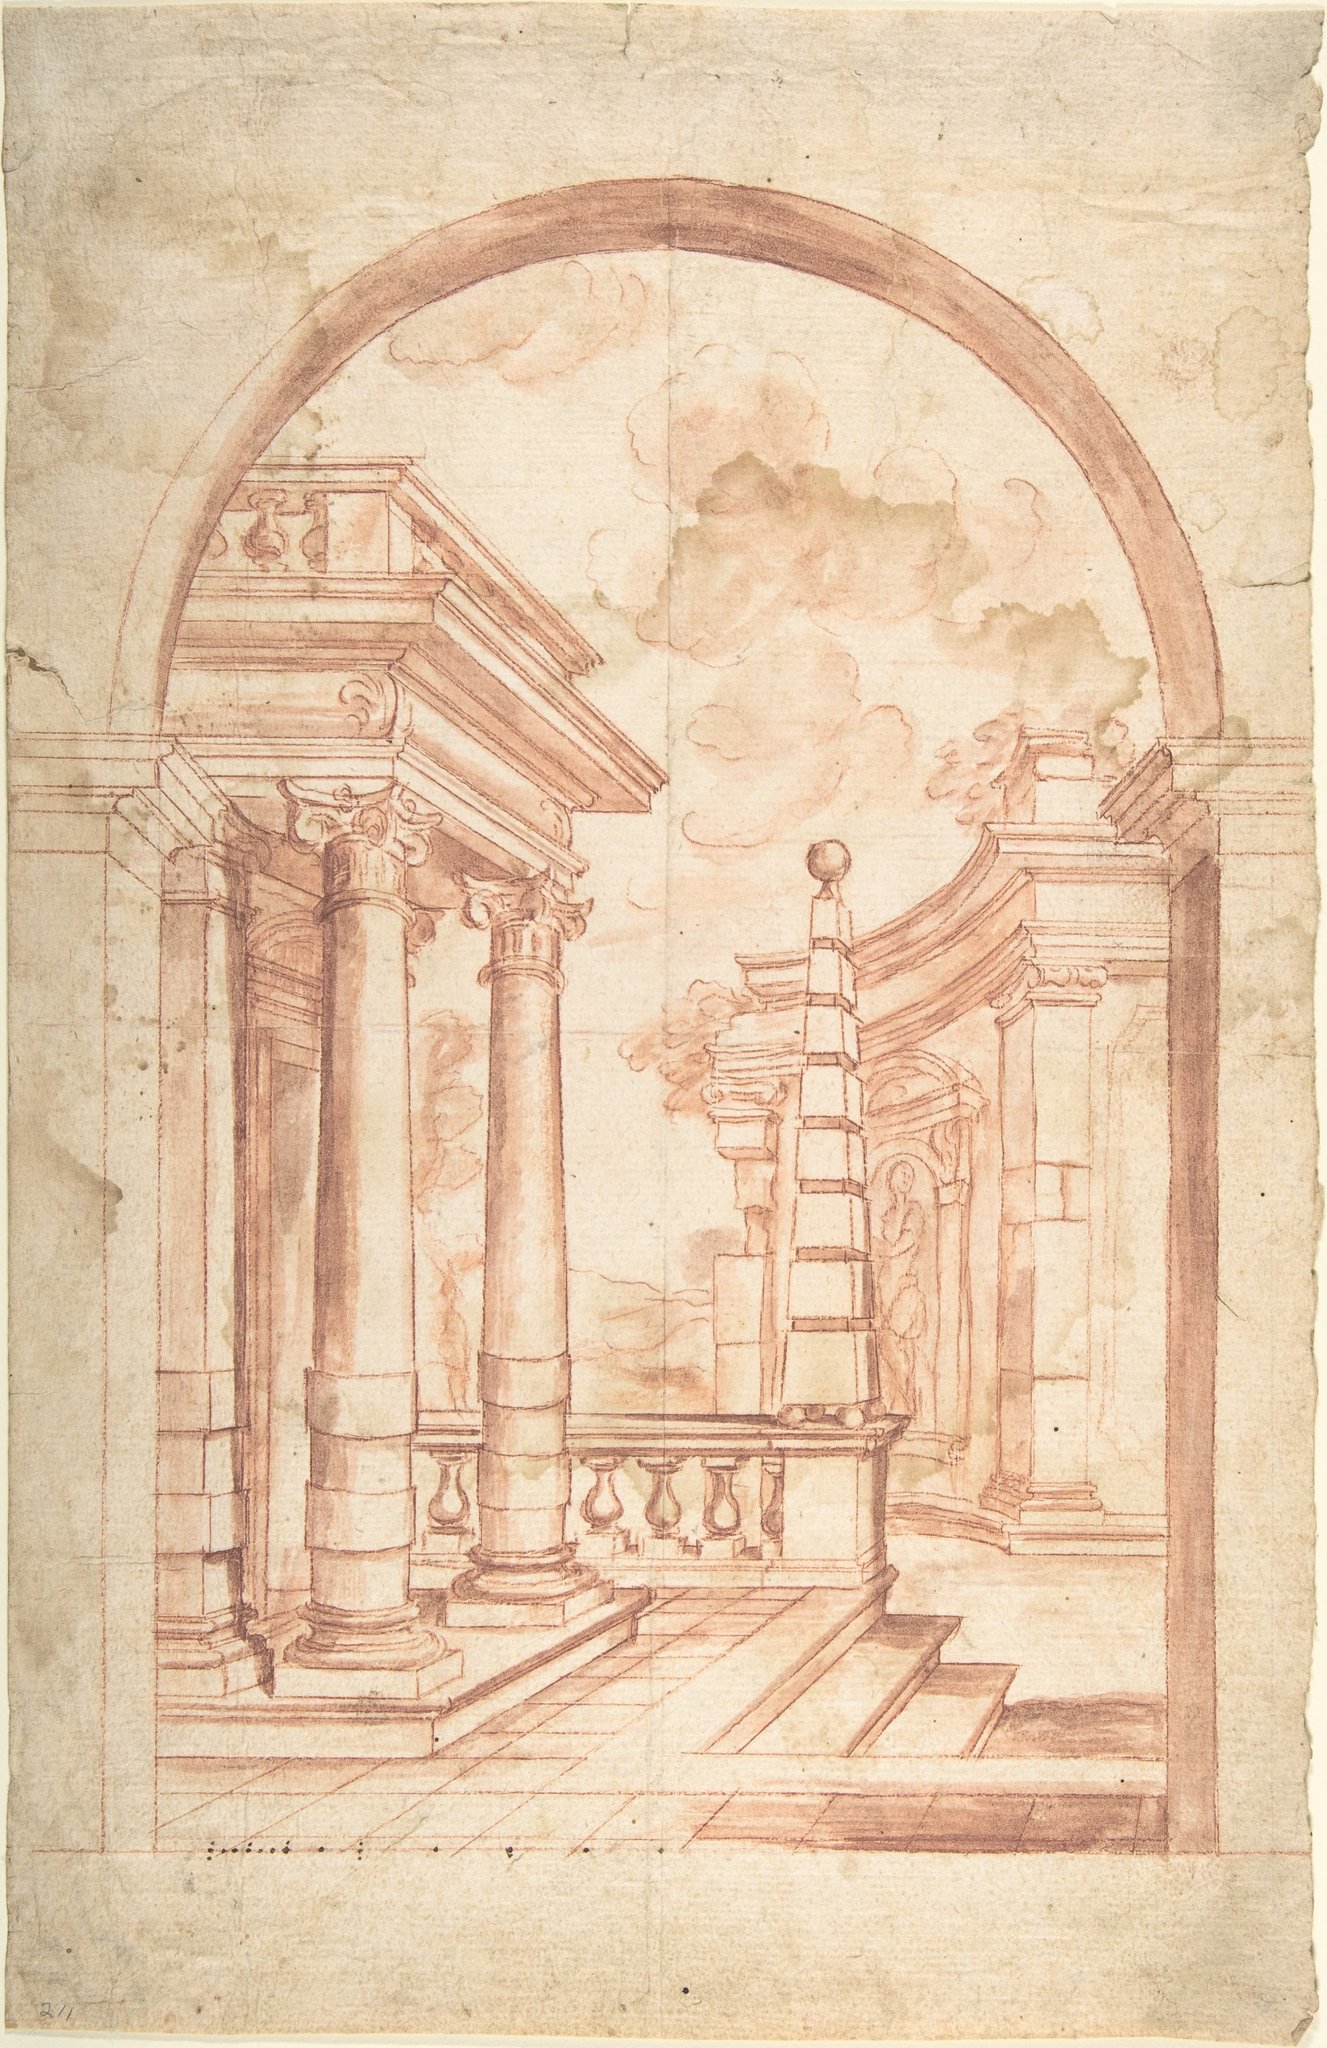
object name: drawing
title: Design of architectural constructions (fantasy)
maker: anonymous, italian, piedmontese, 18th century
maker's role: artist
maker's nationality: italian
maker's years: 1700-1800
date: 1700-1780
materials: chalk, ink, drawing material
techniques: brush, drawing, pen, wash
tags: architecture,columns